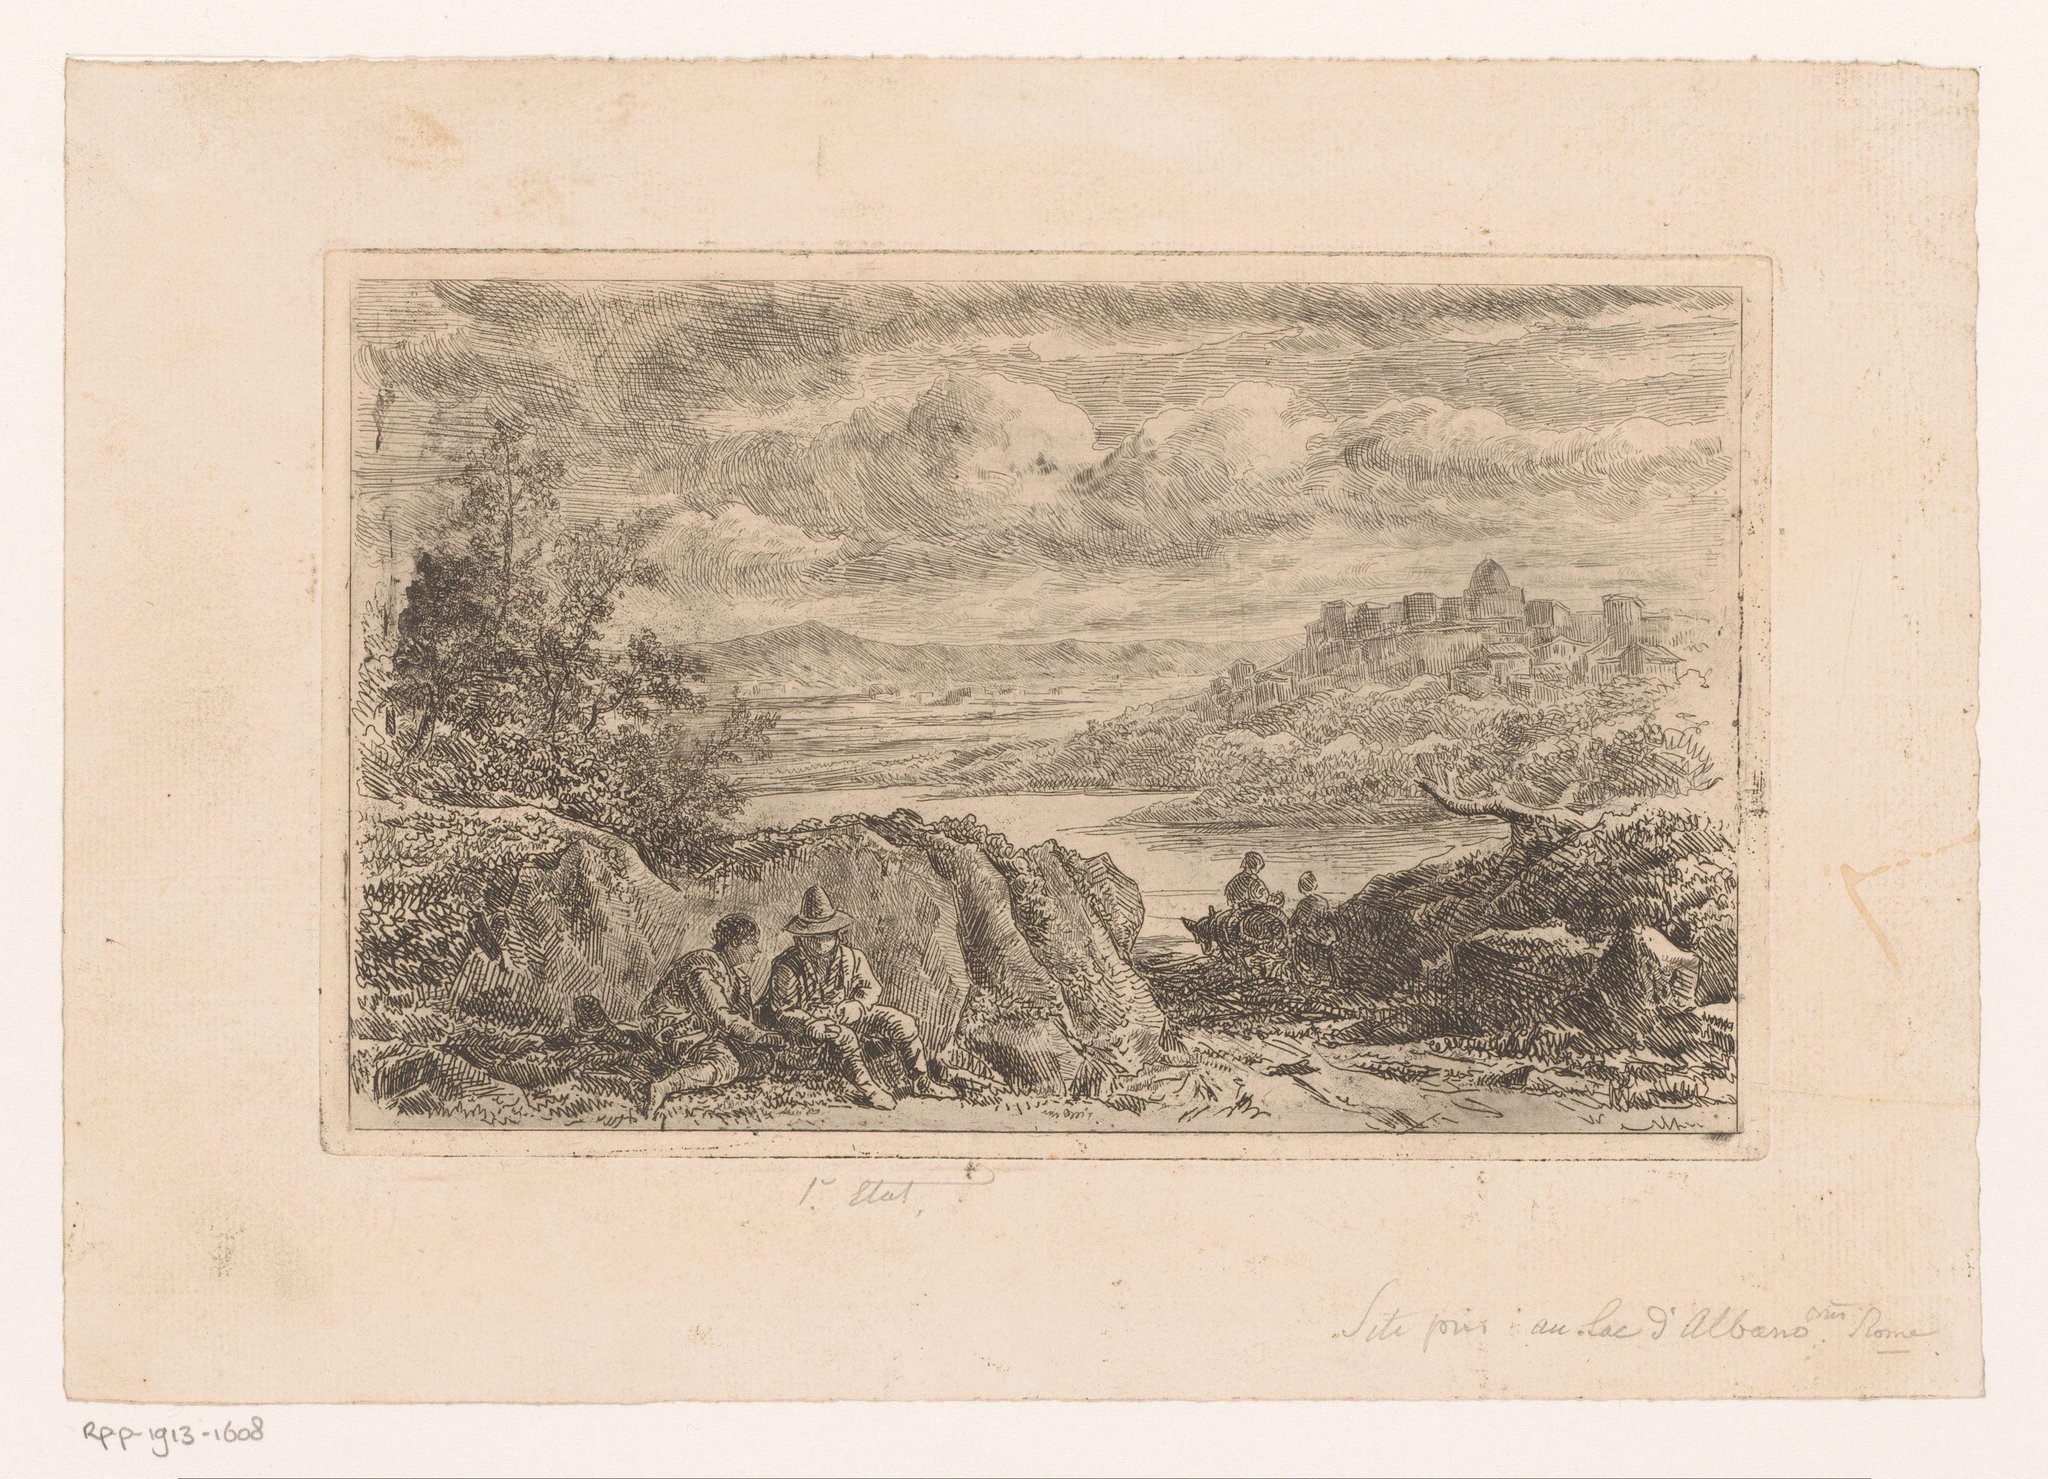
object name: print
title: Gezicht op het meer van Albano en Castel Gandolfo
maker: joseph meganck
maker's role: print maker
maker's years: 1807-1891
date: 1817-1888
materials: paper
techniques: etching, intaglio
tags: riding a horse, ass, or mule; rider, horseman, lake, city-view, and landscape with man-made constructions (+ city(-scape) with figures, staffage)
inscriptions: inscription: ‘1e Etat / Site pris au lac d'Albano [...] Rome’, collector's mark: Lugt 2228